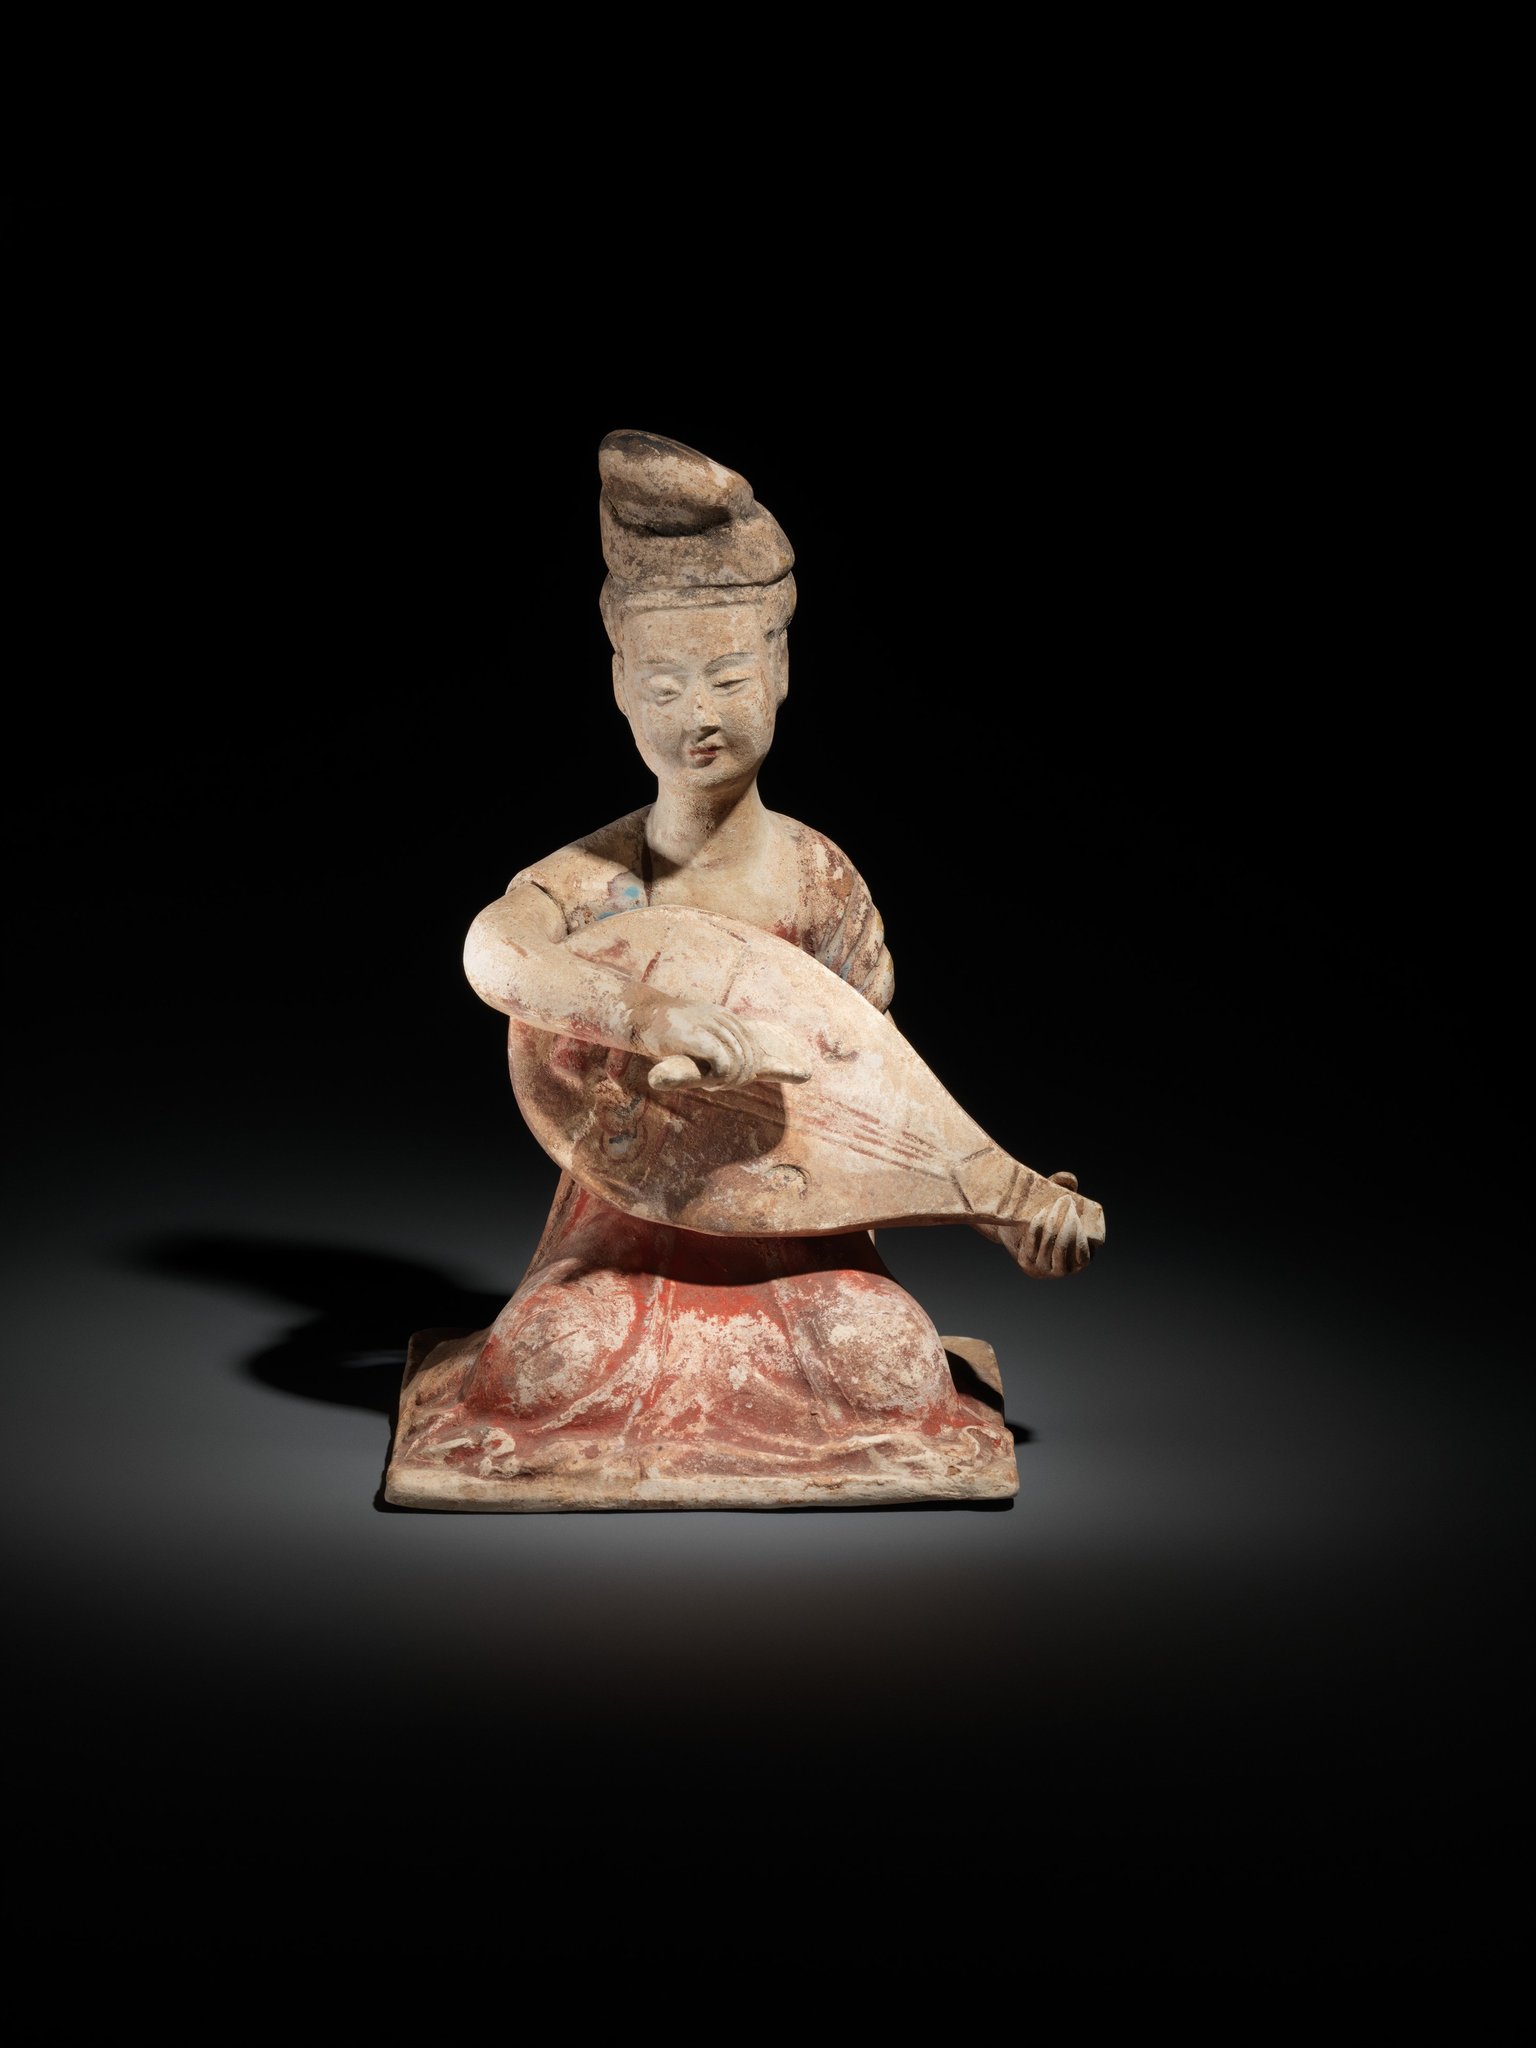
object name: figure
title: Female musician with lute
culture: chinese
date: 667-700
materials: earthenware, pigment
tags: musical instruments,women,musicians